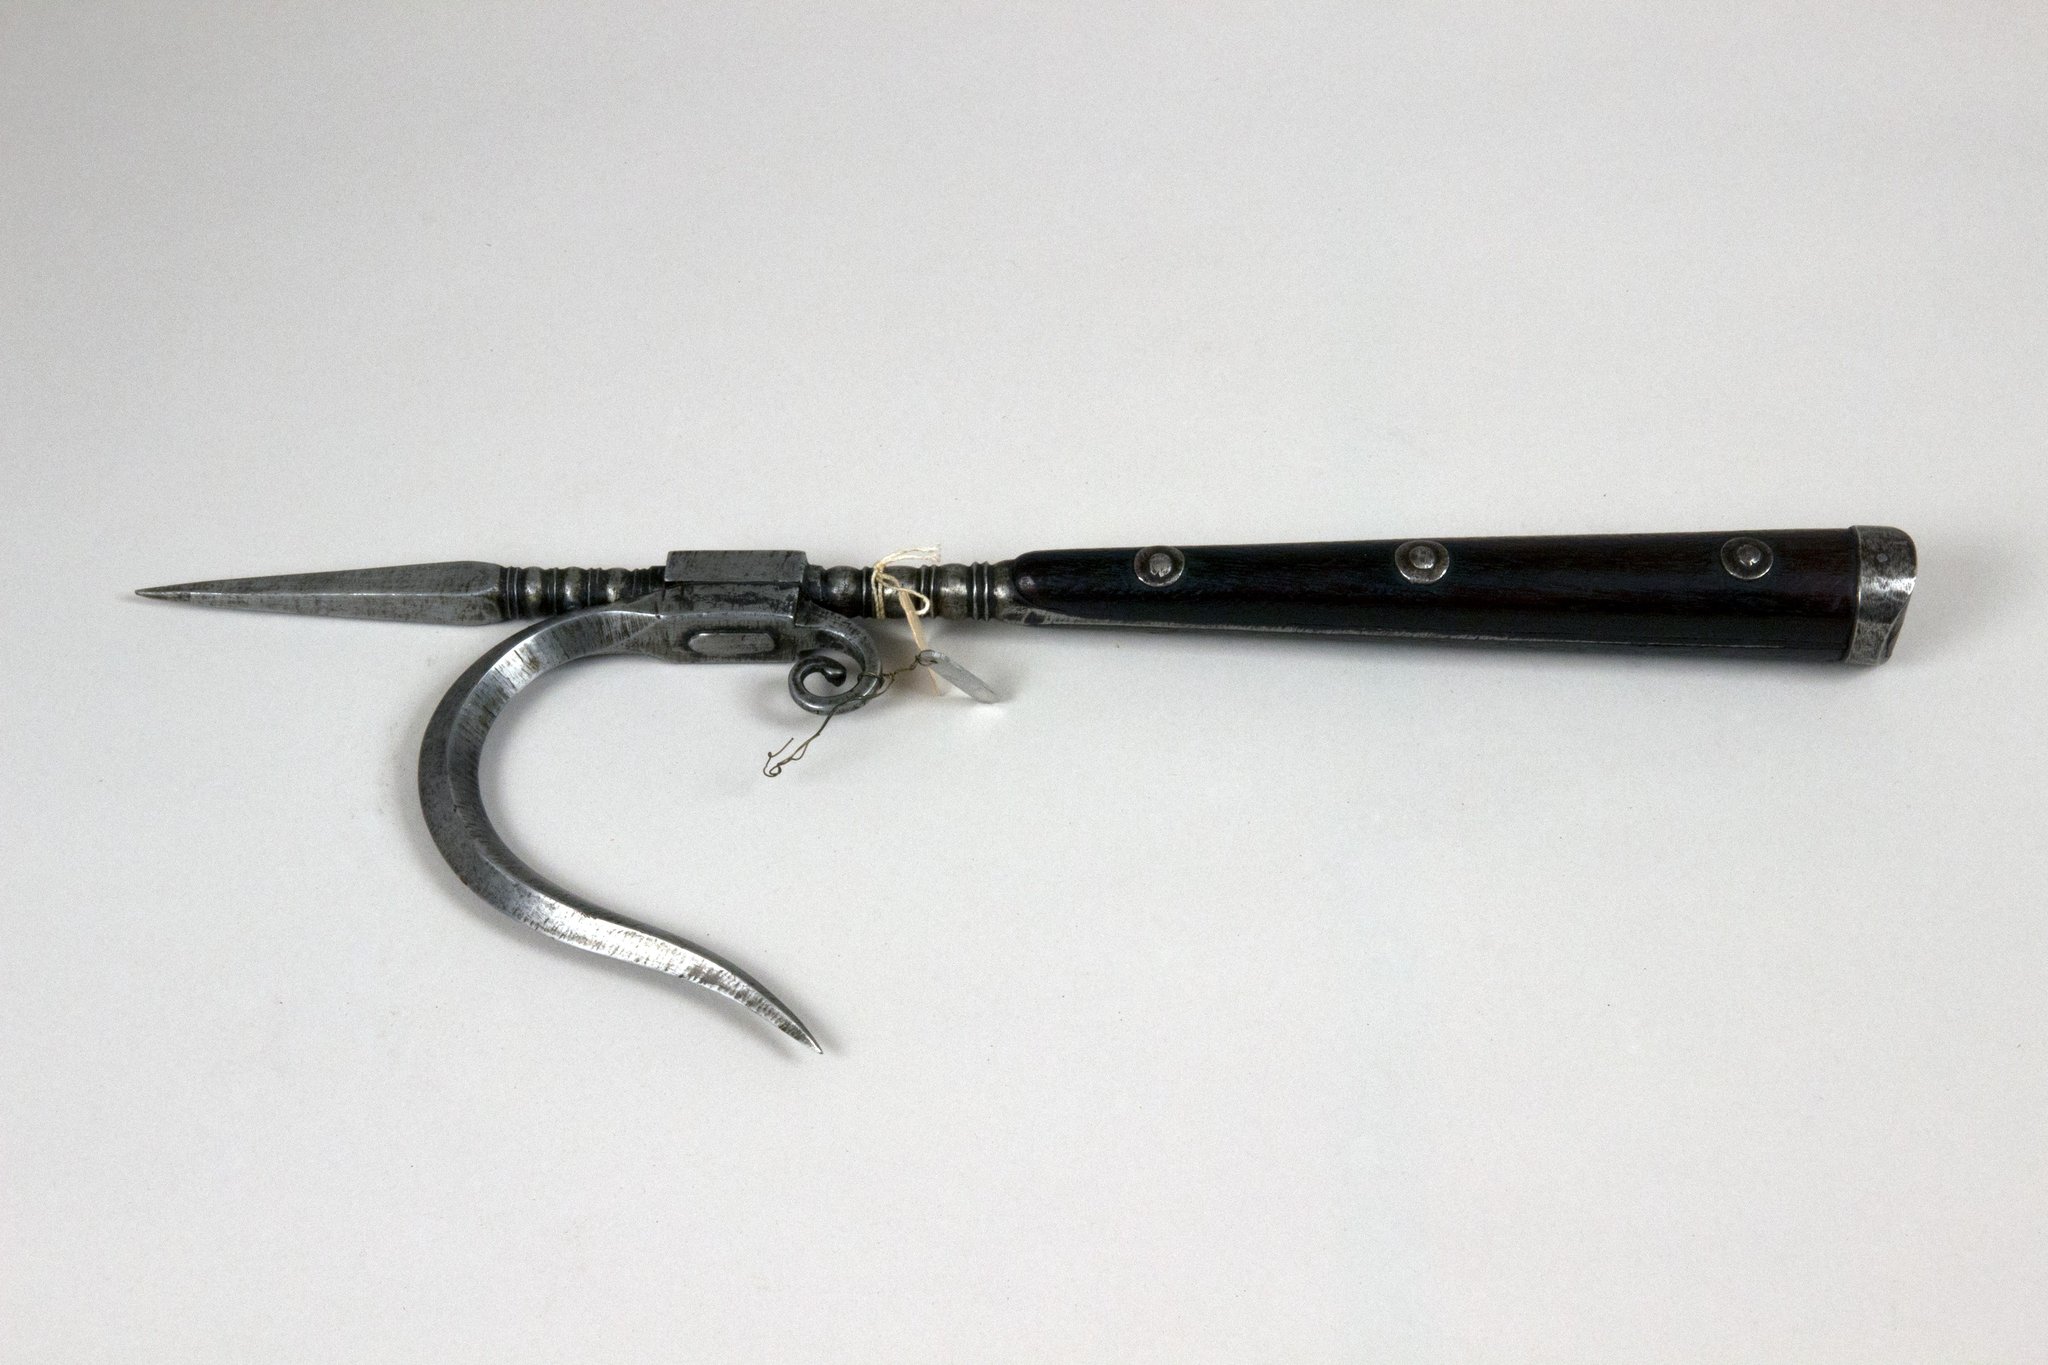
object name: ancus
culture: indian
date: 1701-1900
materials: steel, wood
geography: india